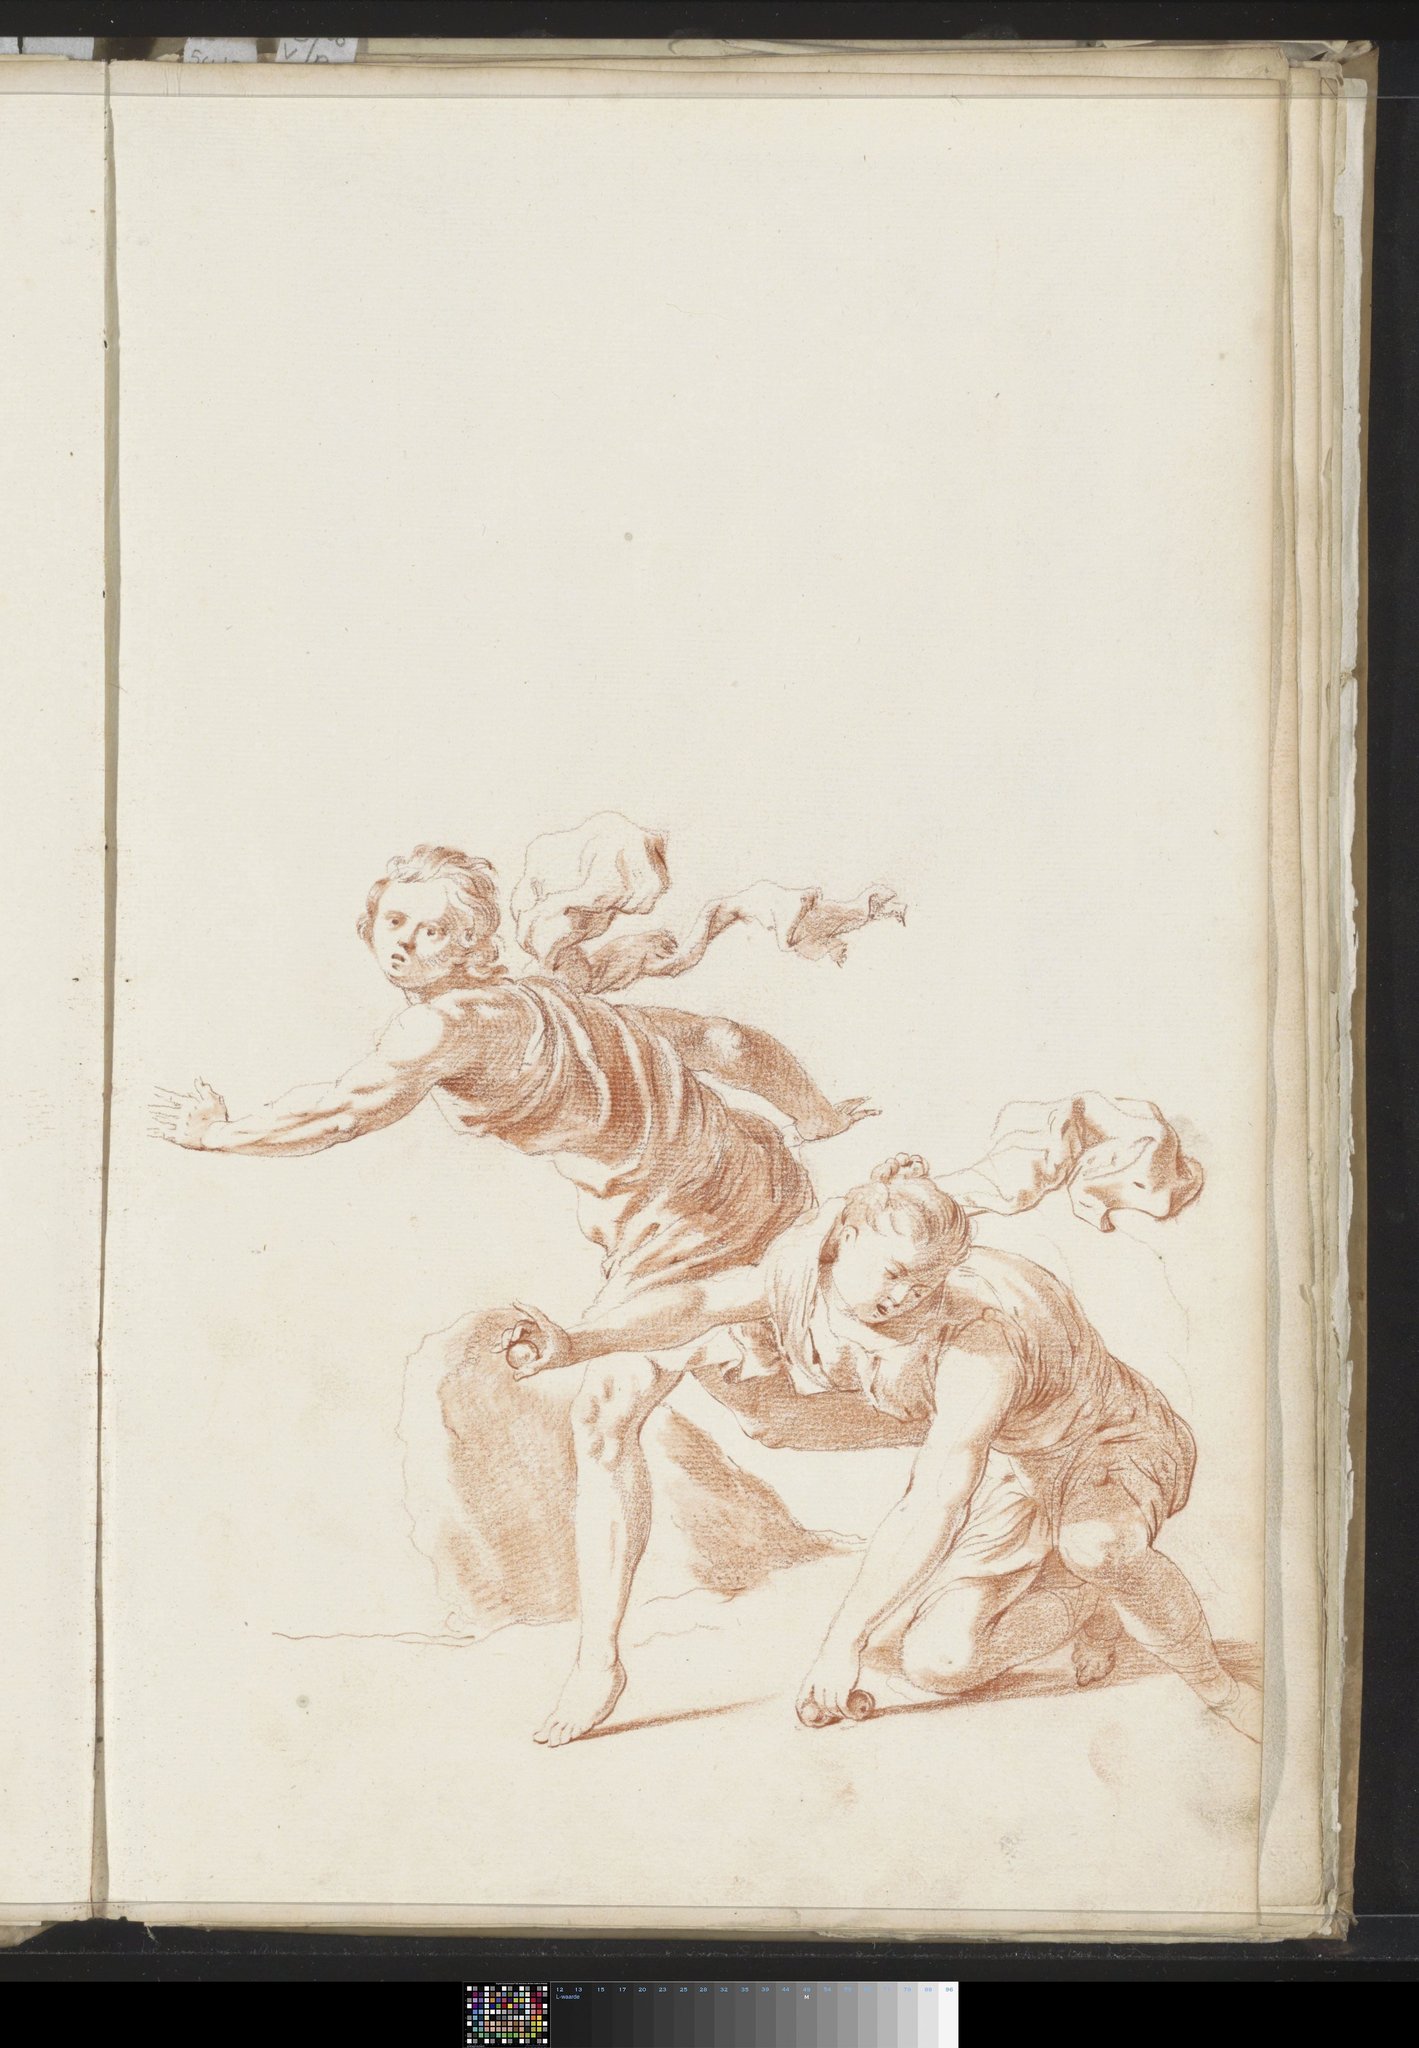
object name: sketchbook leaf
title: Atalanta en Hippomenes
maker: jacob toorenvliet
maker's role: draughtsman, painter, print maker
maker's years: 1640-1719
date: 1701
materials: chalk, paper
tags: atalante and hippomenes (or meilanion)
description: Atalanta neemt deel in een hardloopwedstrijd met Hippomenes. Tijdens de wedstrijd laat hij drie gouden ballen vallen die hij van Venus had gekregen. Atalanta kan de verleiding niet weerstaan de ballen op te rapen, waardoor ze de wedstrijd verliest. Blad 52 recto uit een schetsboek met 63 bladen.